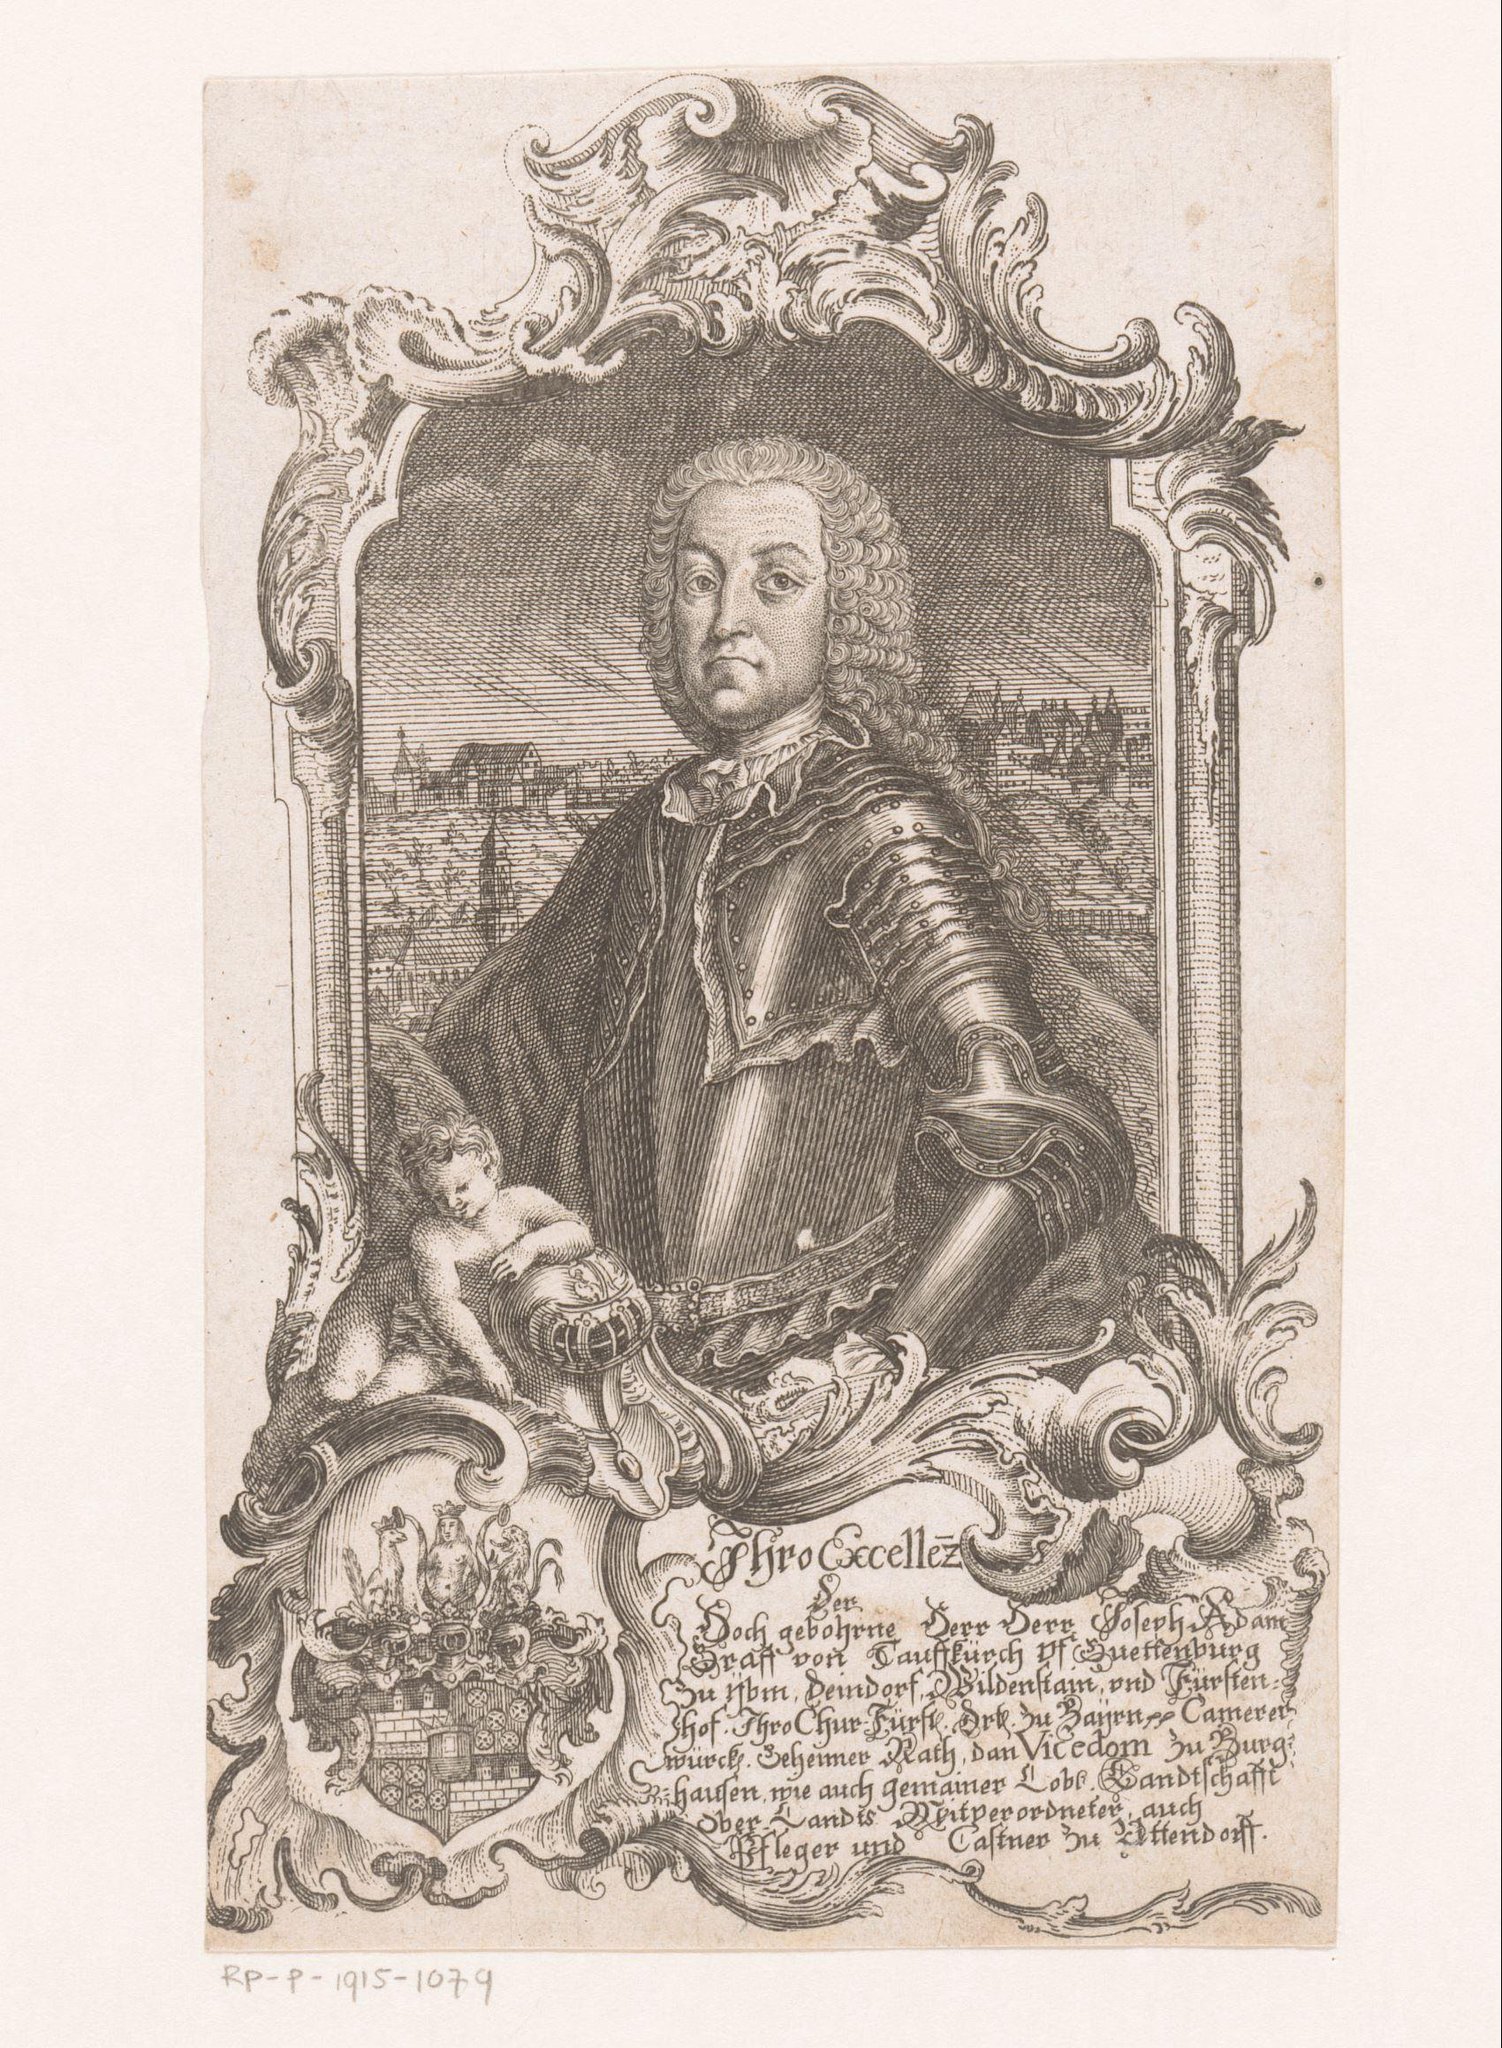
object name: print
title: Portret van Joseph Adam von Taufkirch auf Guttenberg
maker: joseph anton zimmermann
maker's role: draughtsman, print maker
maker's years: 1705-1797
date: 1715-1797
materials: paper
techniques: engraving, etching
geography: germany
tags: historical persons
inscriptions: collector's mark: Lugt 2228